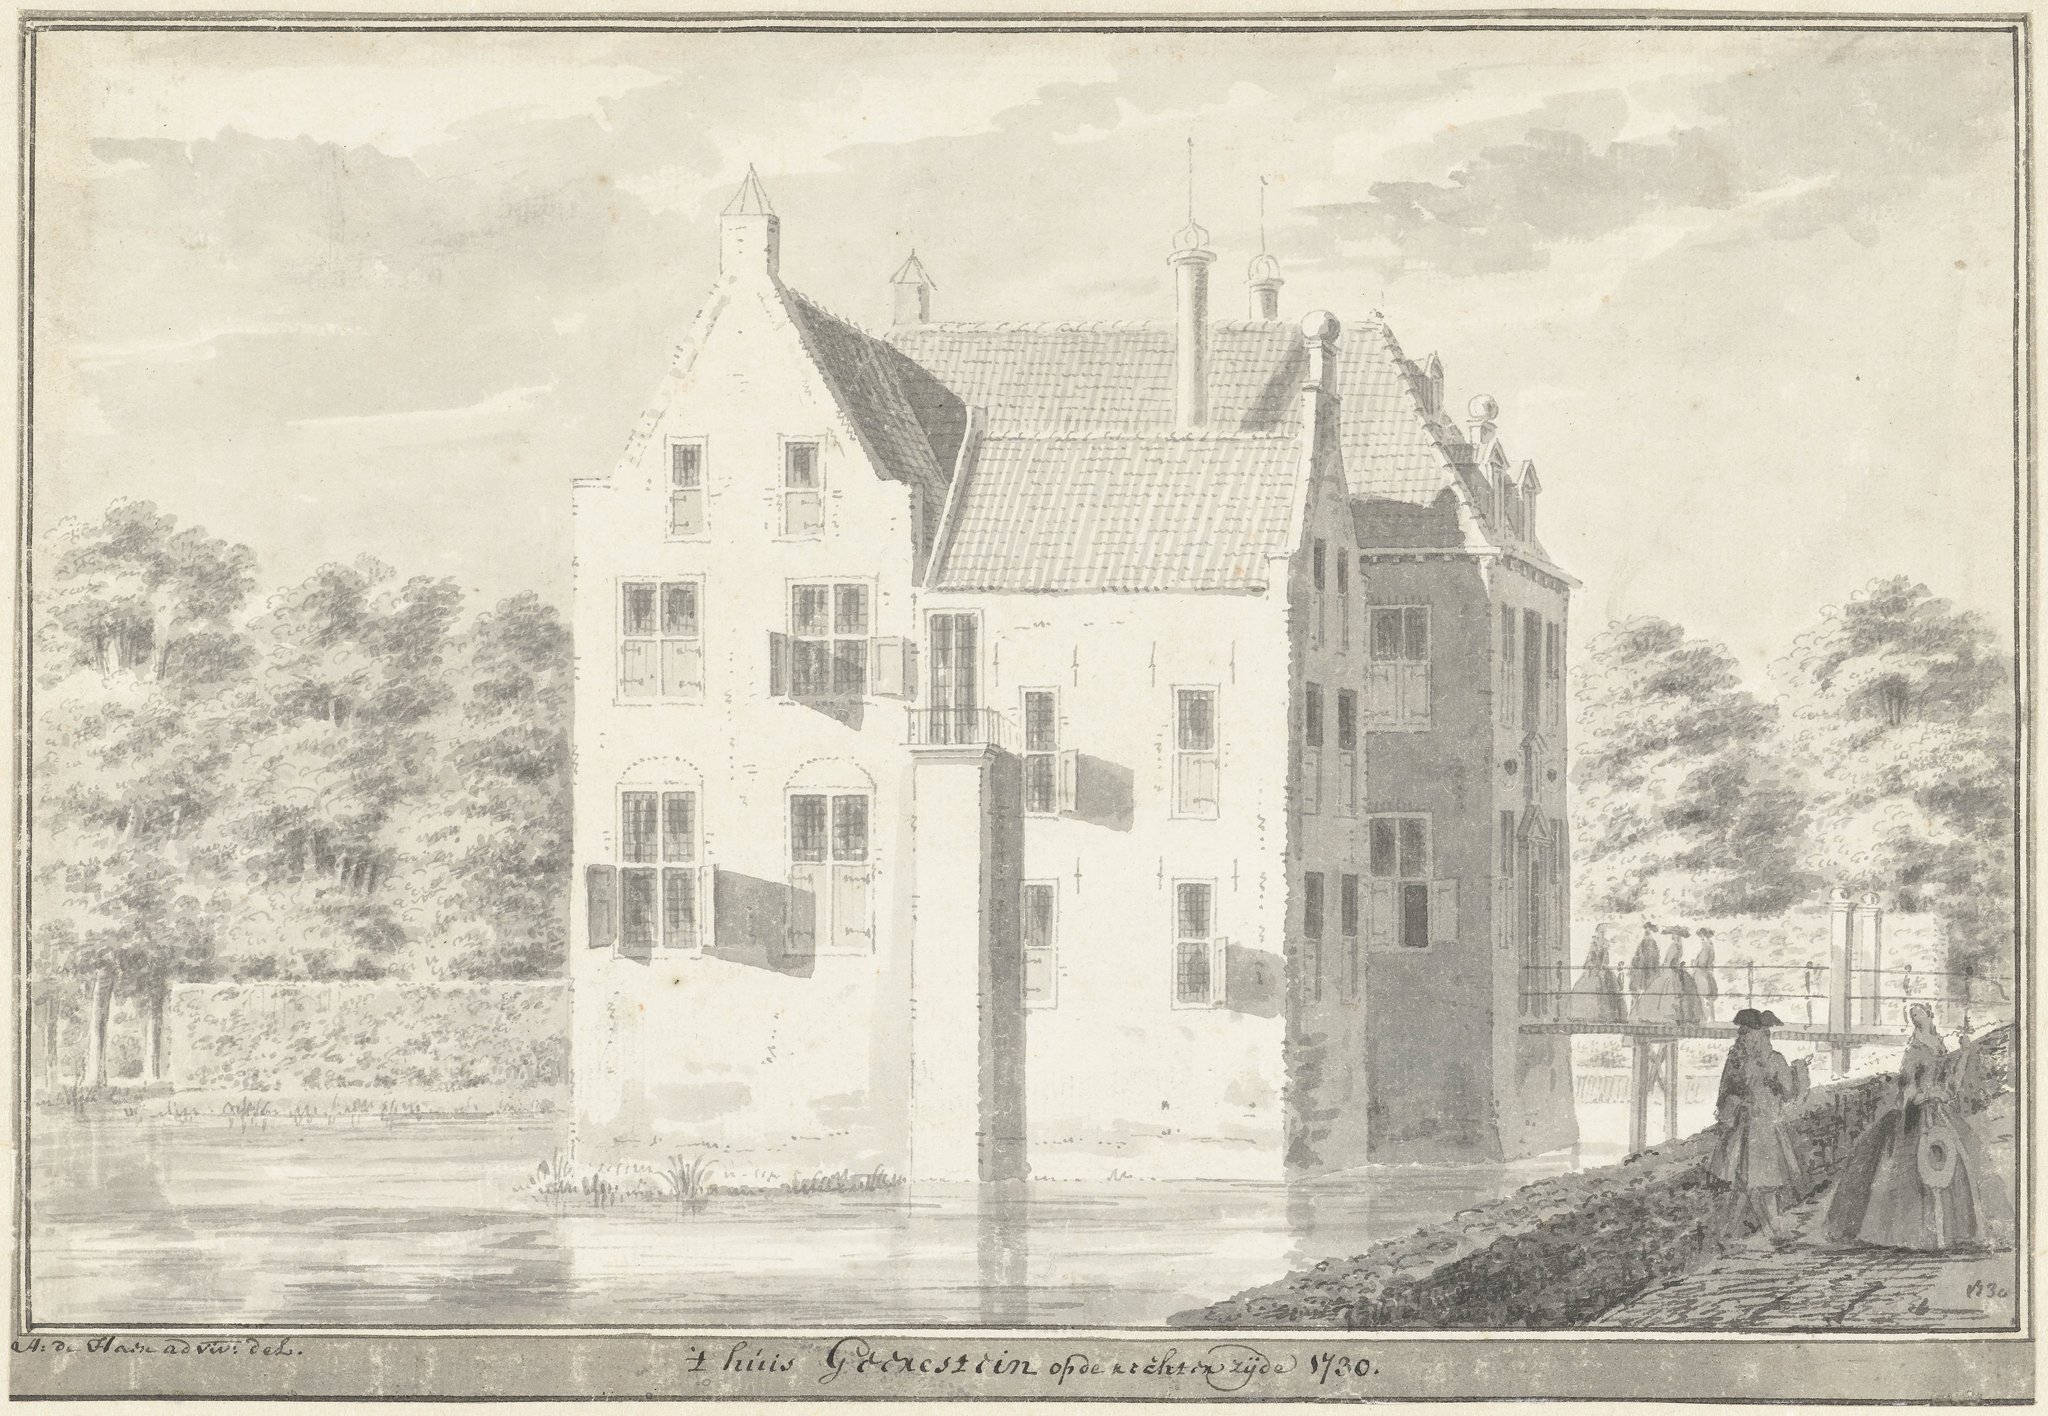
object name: drawing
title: Het kasteel Geerestein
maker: abraham de haen (ii)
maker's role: draughtsman, print maker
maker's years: 1707-1748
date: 1730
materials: ink, paper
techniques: brush, pen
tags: castle